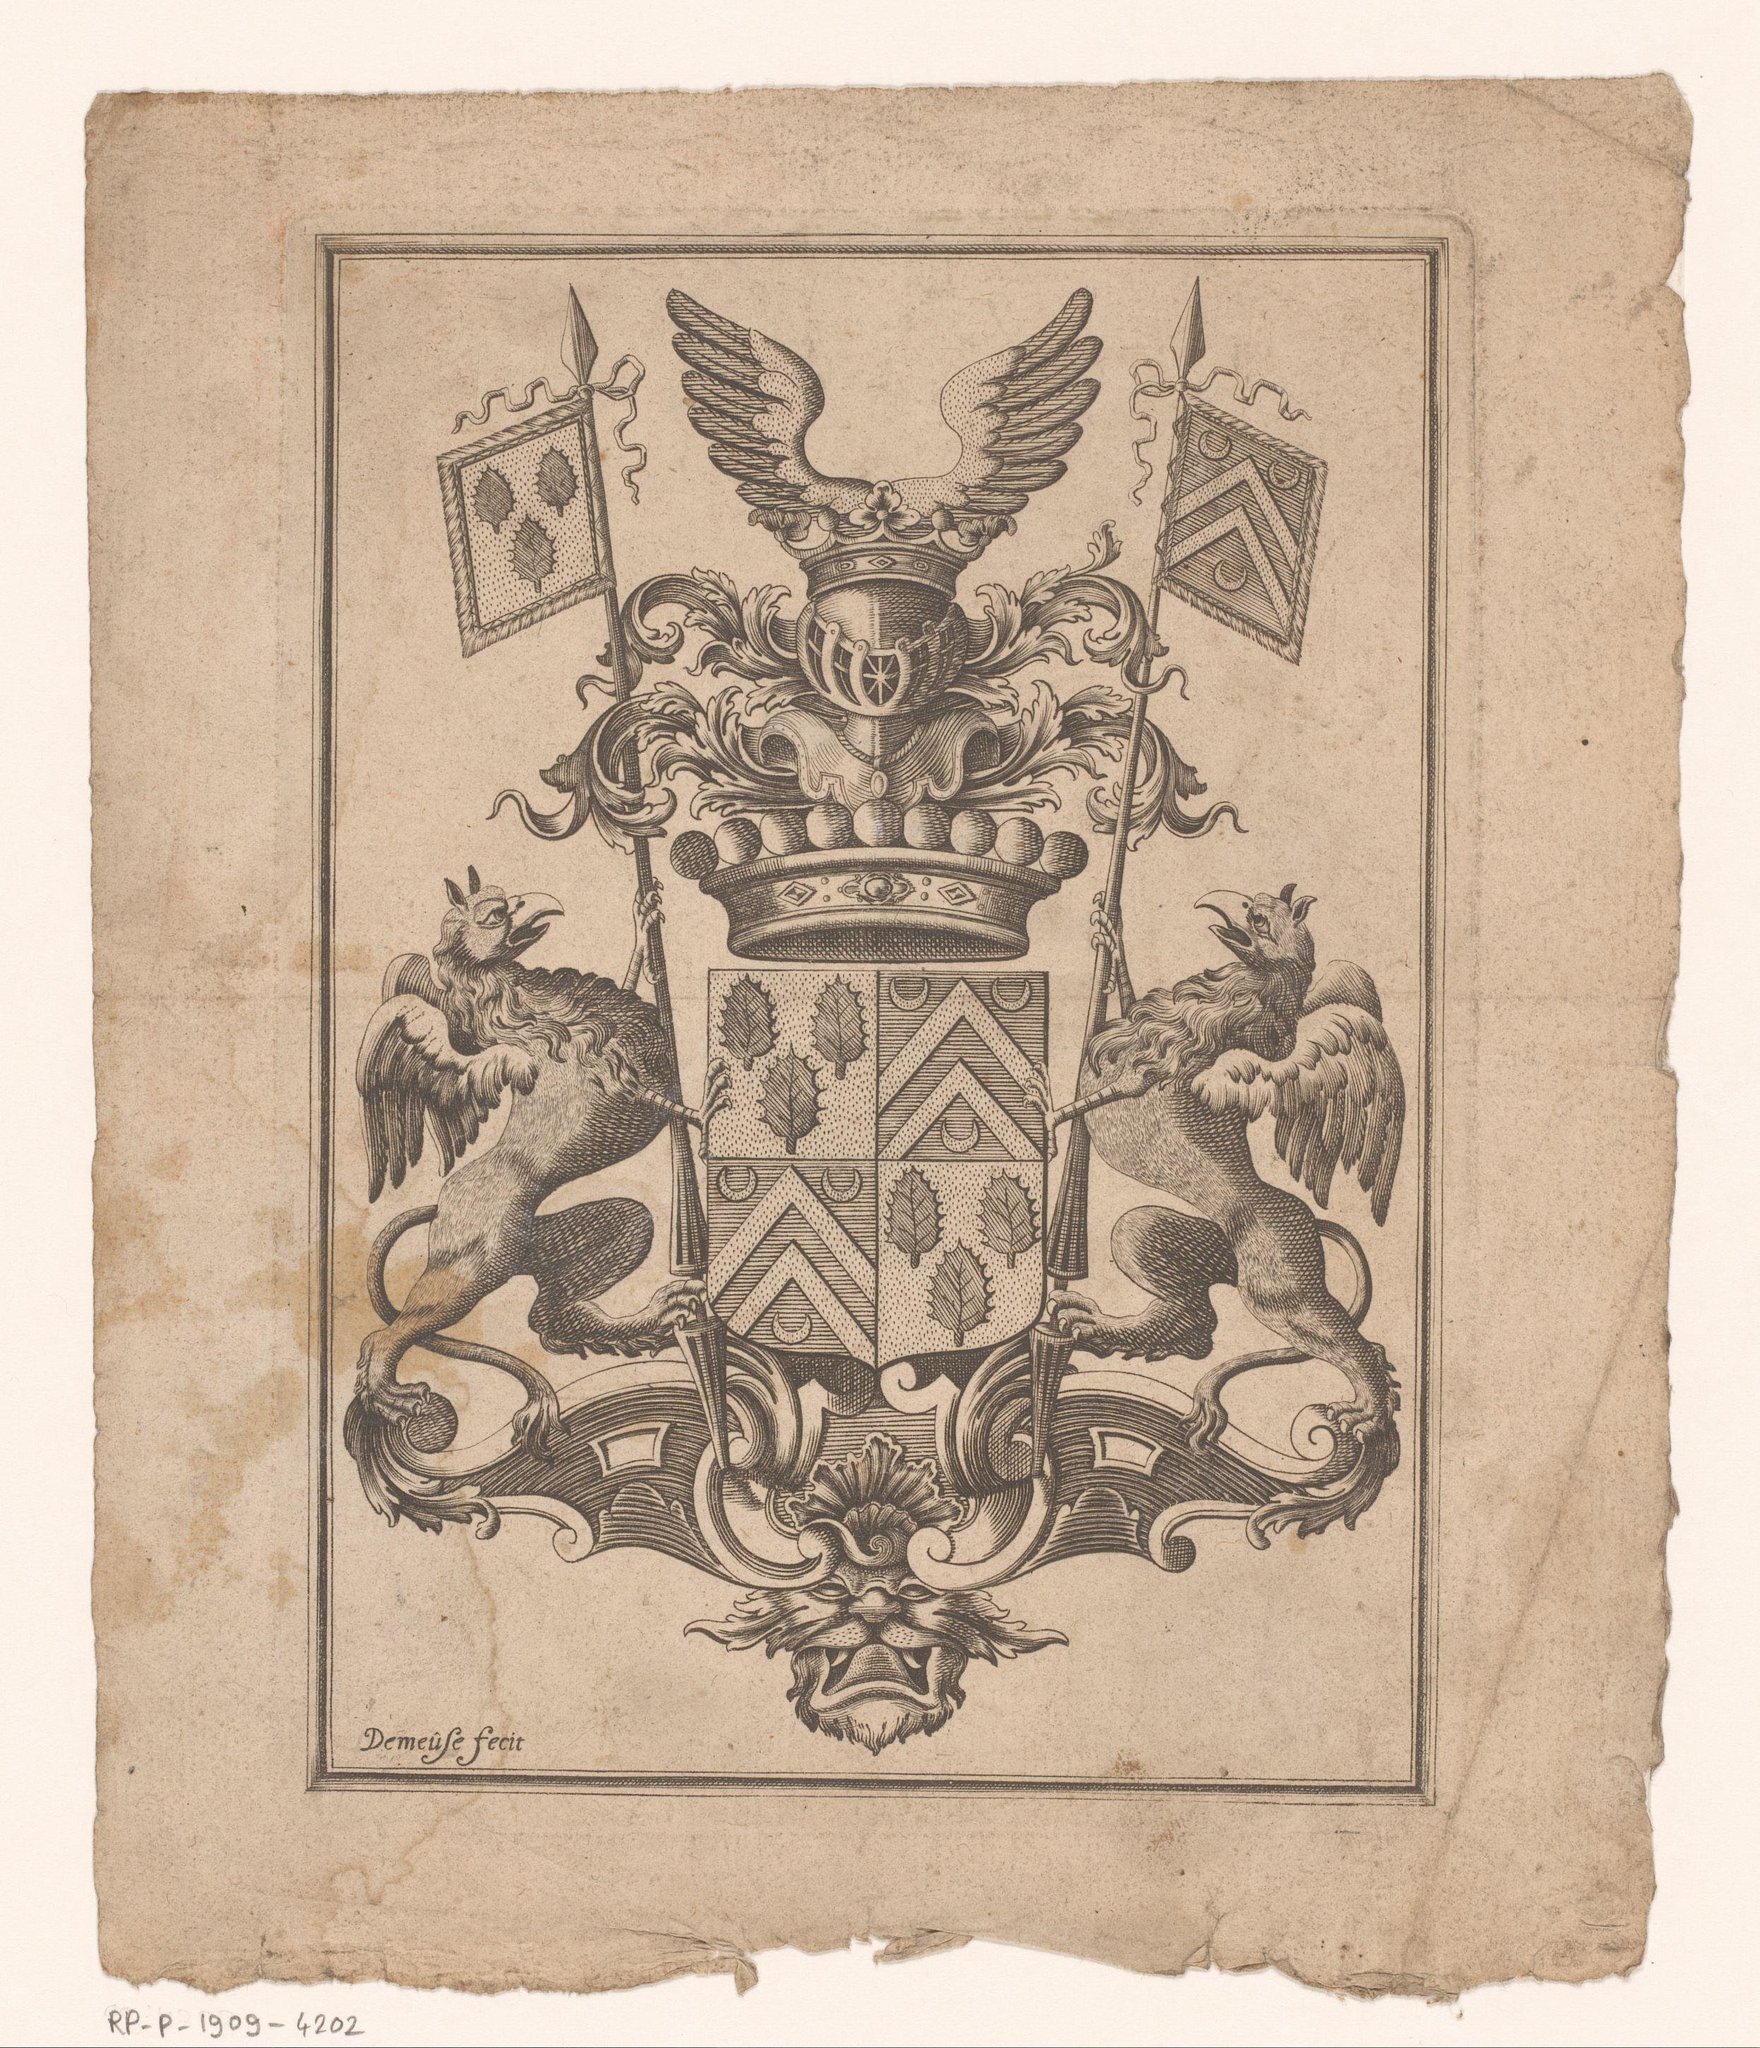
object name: print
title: Wapenschild met twee griffioenen en een gevleugelde helm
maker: louis demeuse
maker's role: print maker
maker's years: -1776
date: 1700-1776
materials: paper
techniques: engraving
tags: griffin (lion/eagle); 'griffo' (ripa), armorial bearing, heraldry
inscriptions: collector's mark: Lugt 2228